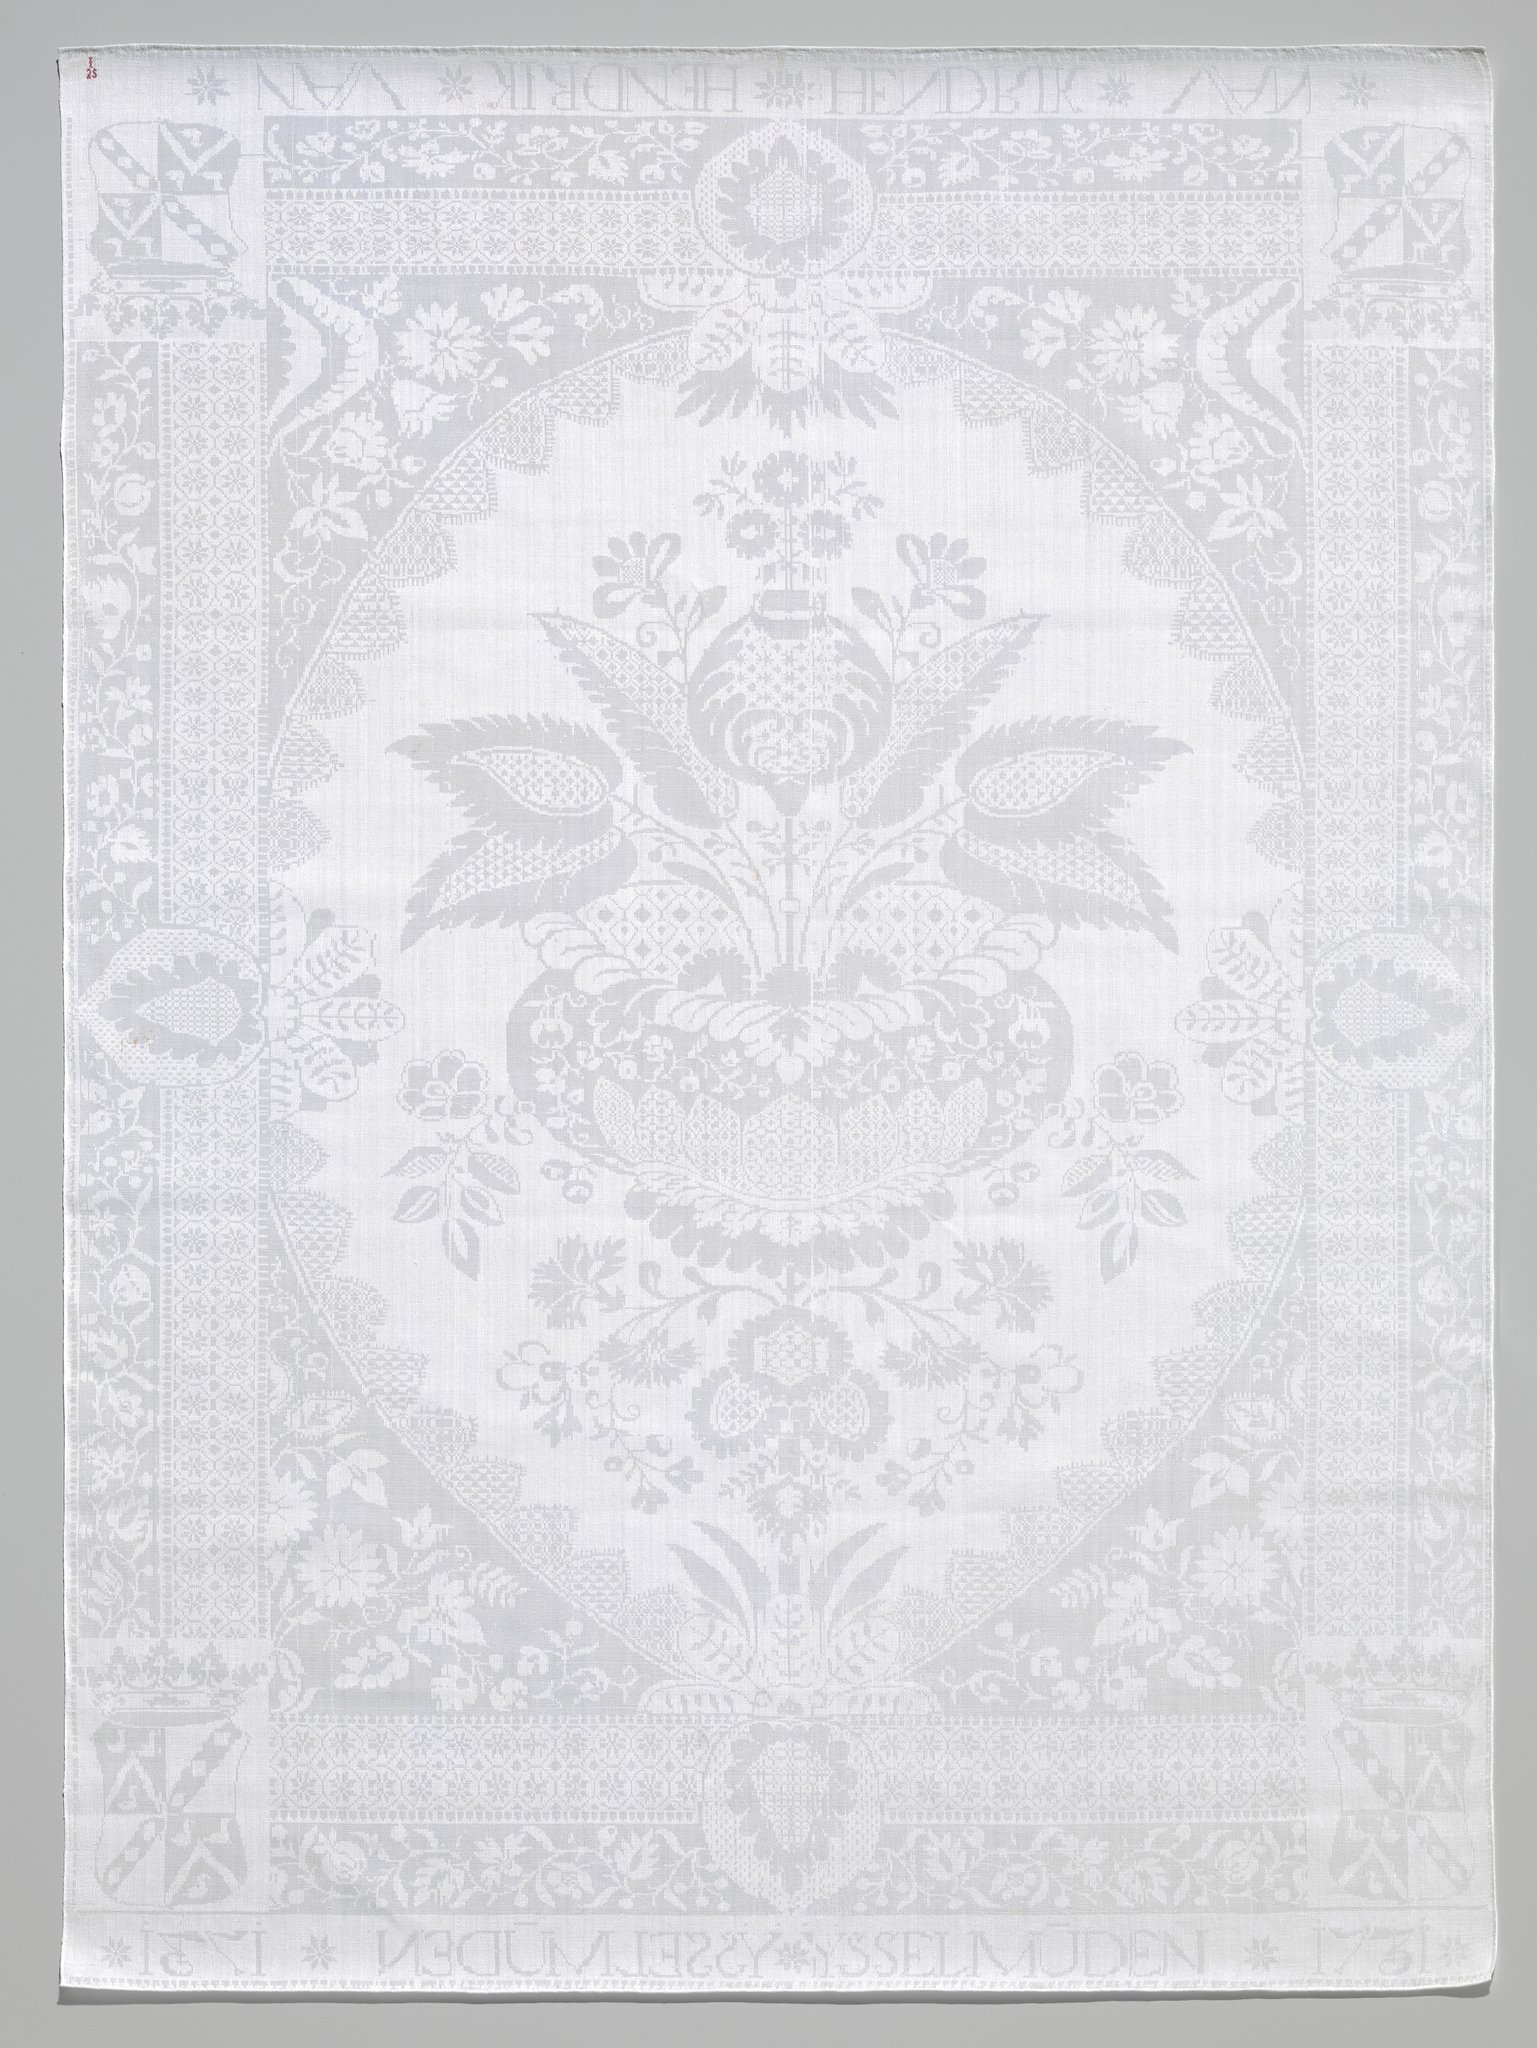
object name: napkin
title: Servet van wit linnendamast met kantpatroon en naam- en wapeninweving van Hendrik van Isselmuden en jaartal 1731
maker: Anonymous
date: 1731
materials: linen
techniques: damask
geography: flanders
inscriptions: date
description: Servet van wit linnendamast met kantpatroon en naam- en wapeninweving van Hendrik van Isselmuden en jaartal 1731.